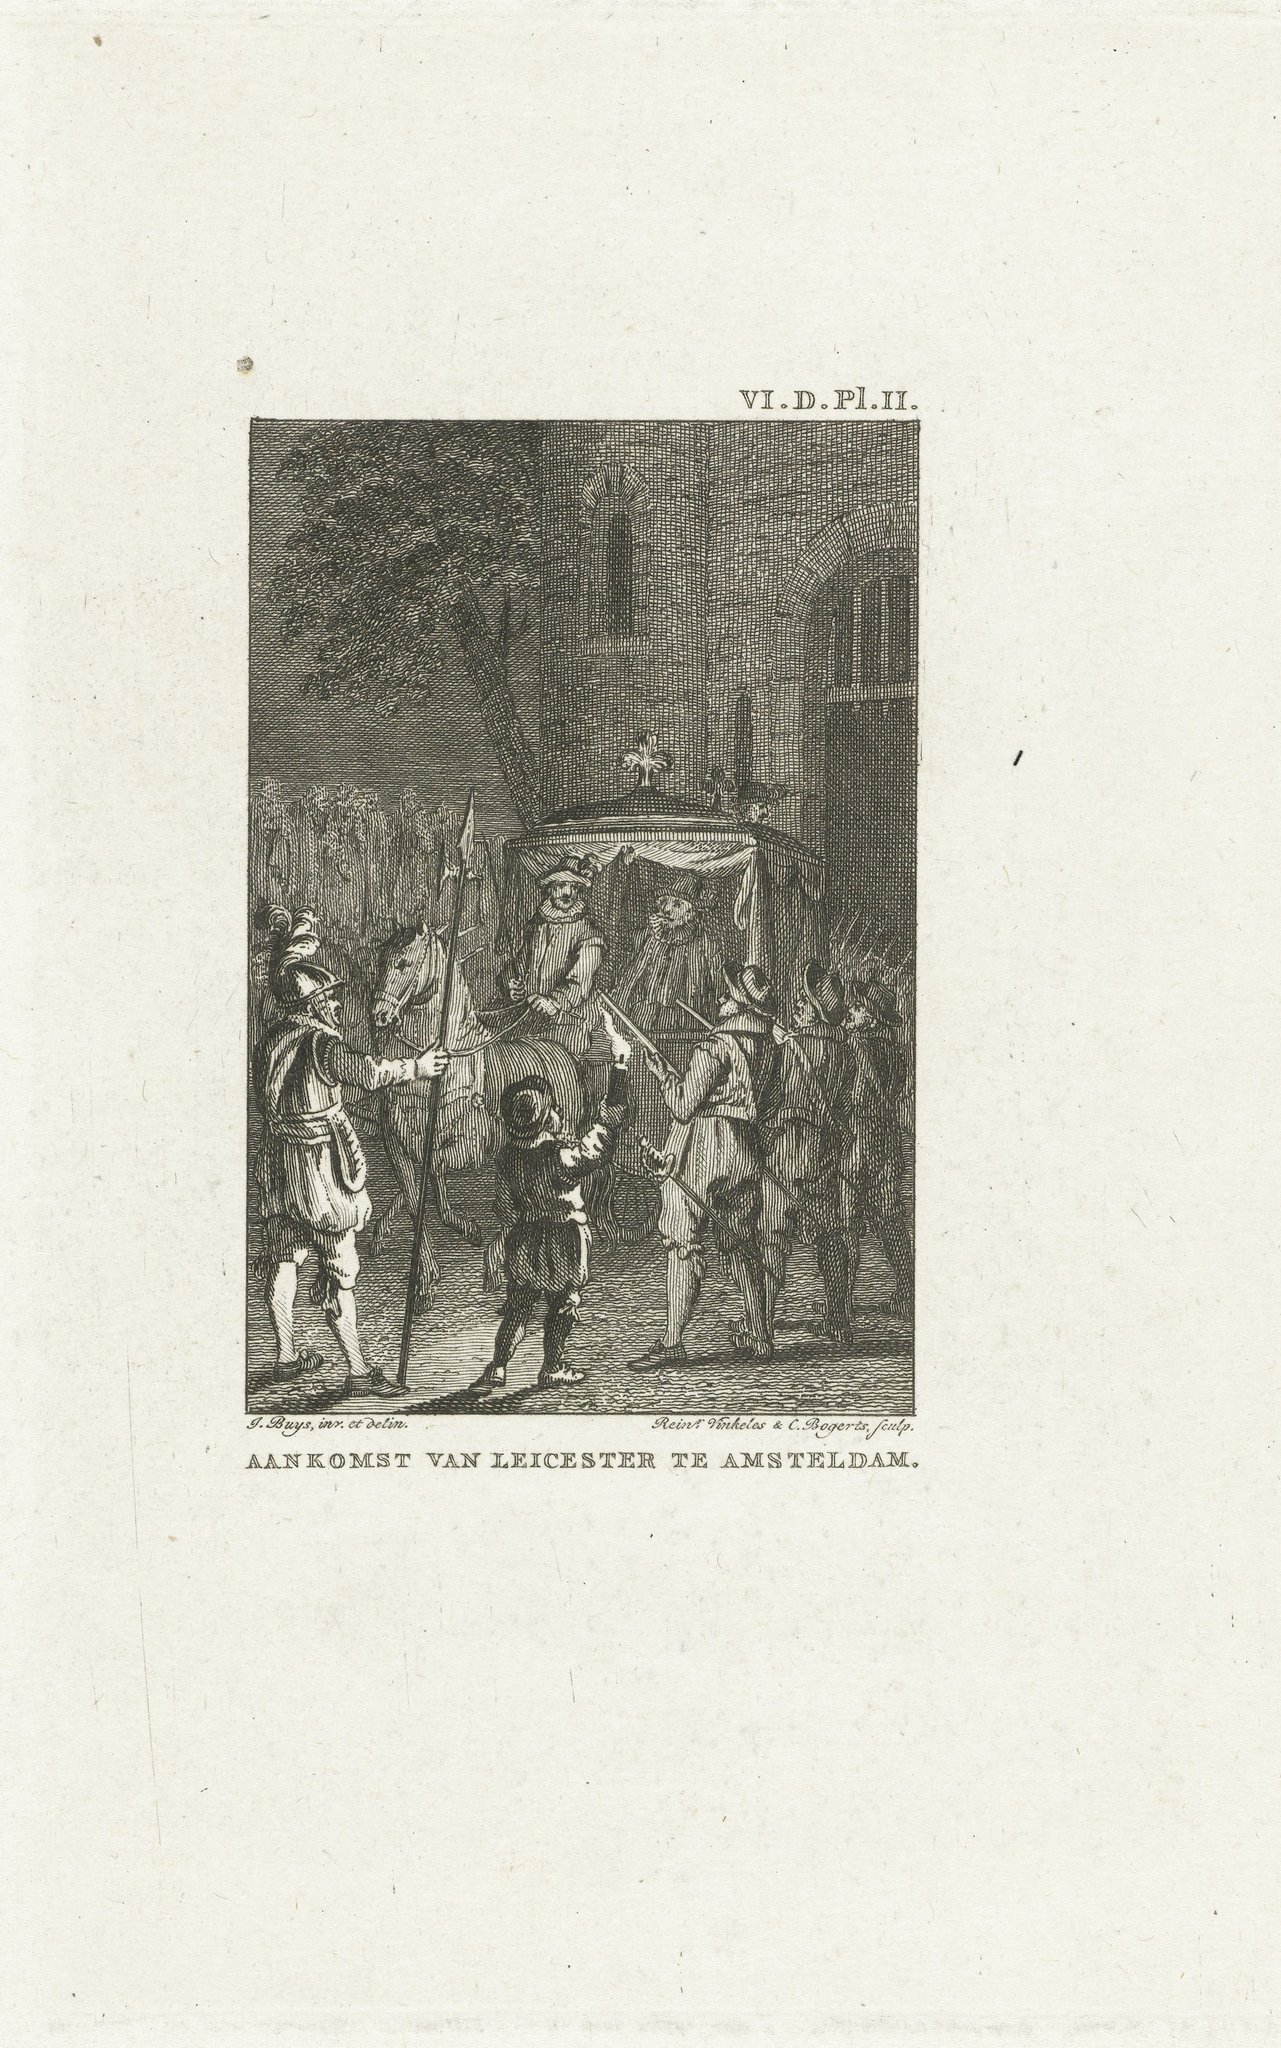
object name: history print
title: Aankomst van Leicester te Amsteldam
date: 1780-1795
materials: paper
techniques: etching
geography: netherlands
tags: robert dudley (1st earl of leicester), amsterdam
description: Gebruikt als illustratie in: J. Fokke, Geschiedenissen der Vereenigde Nederlanden voor de vaderlandsche jeugd, Johannes Allart, Amsterdam 1783-1795, 25 delen, dl. VI, pl. II.